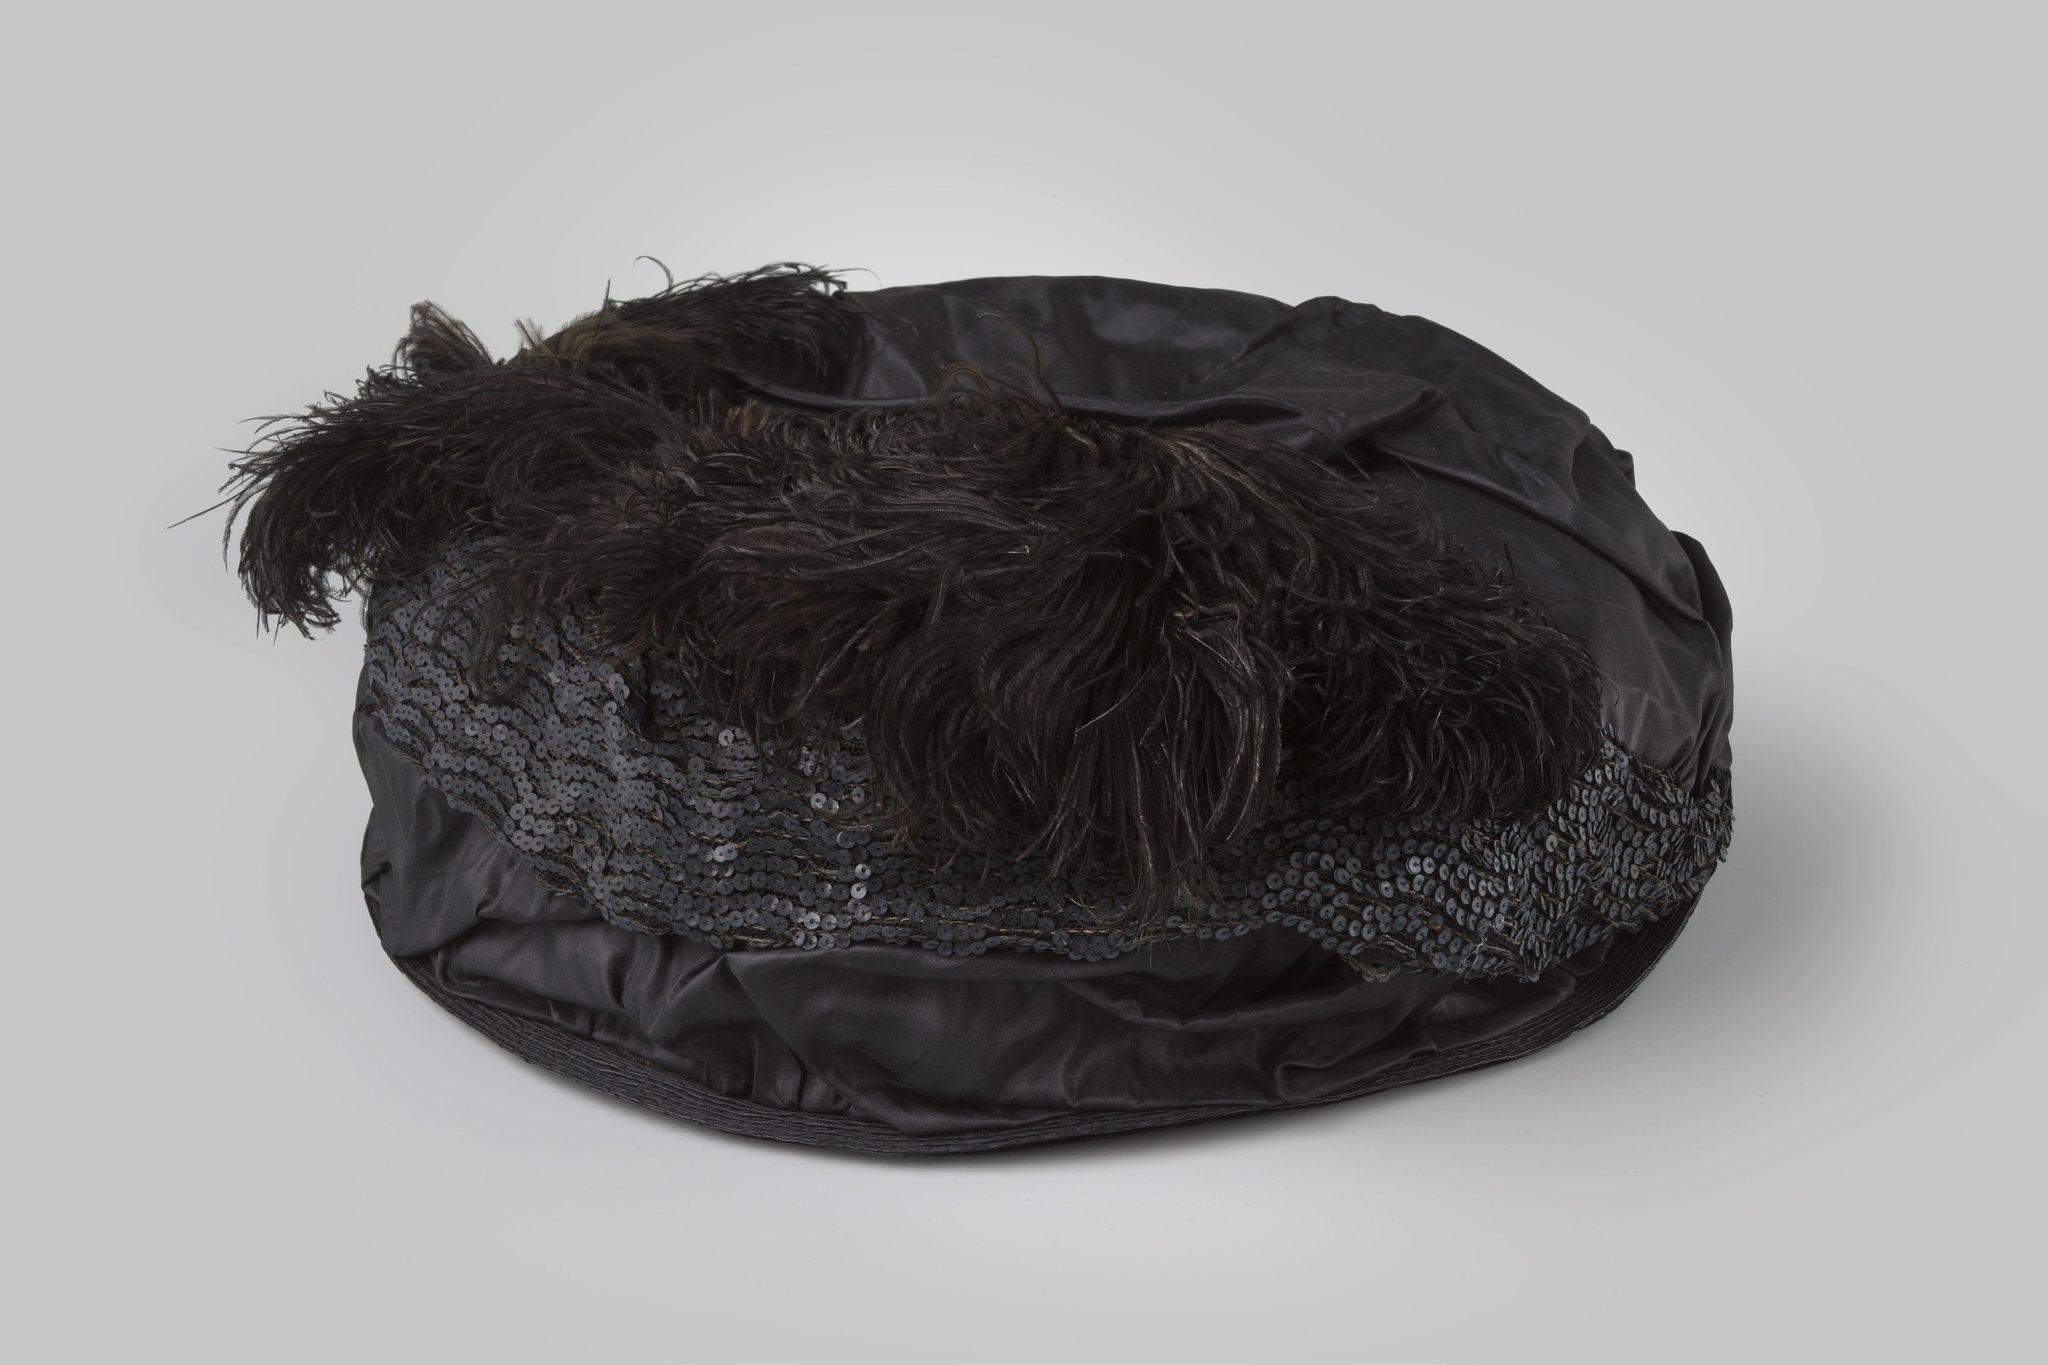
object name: womenswear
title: Hoed van zwart stro belegd met zwarte moirézijde en versierd met lovertjes en struisveren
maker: Anonymous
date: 1910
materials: silk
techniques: weave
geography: europe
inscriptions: mark: ‘Gebhard 1910’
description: Hoed van zwart stro. Model: toque-model, met binnenhoed met strooien rand. Versiering: over het geheel is een gedrapeerde moirézijde gehecht. Links vóór nog een extra belegstuk in tule, vol met lovertjes in golvende lijnen. De rand is van binnen met zwarte fluweeltjes belegd en in de achterhelft van de entree een ruche van tule. Vanachter een elastieklusje met een balletje.